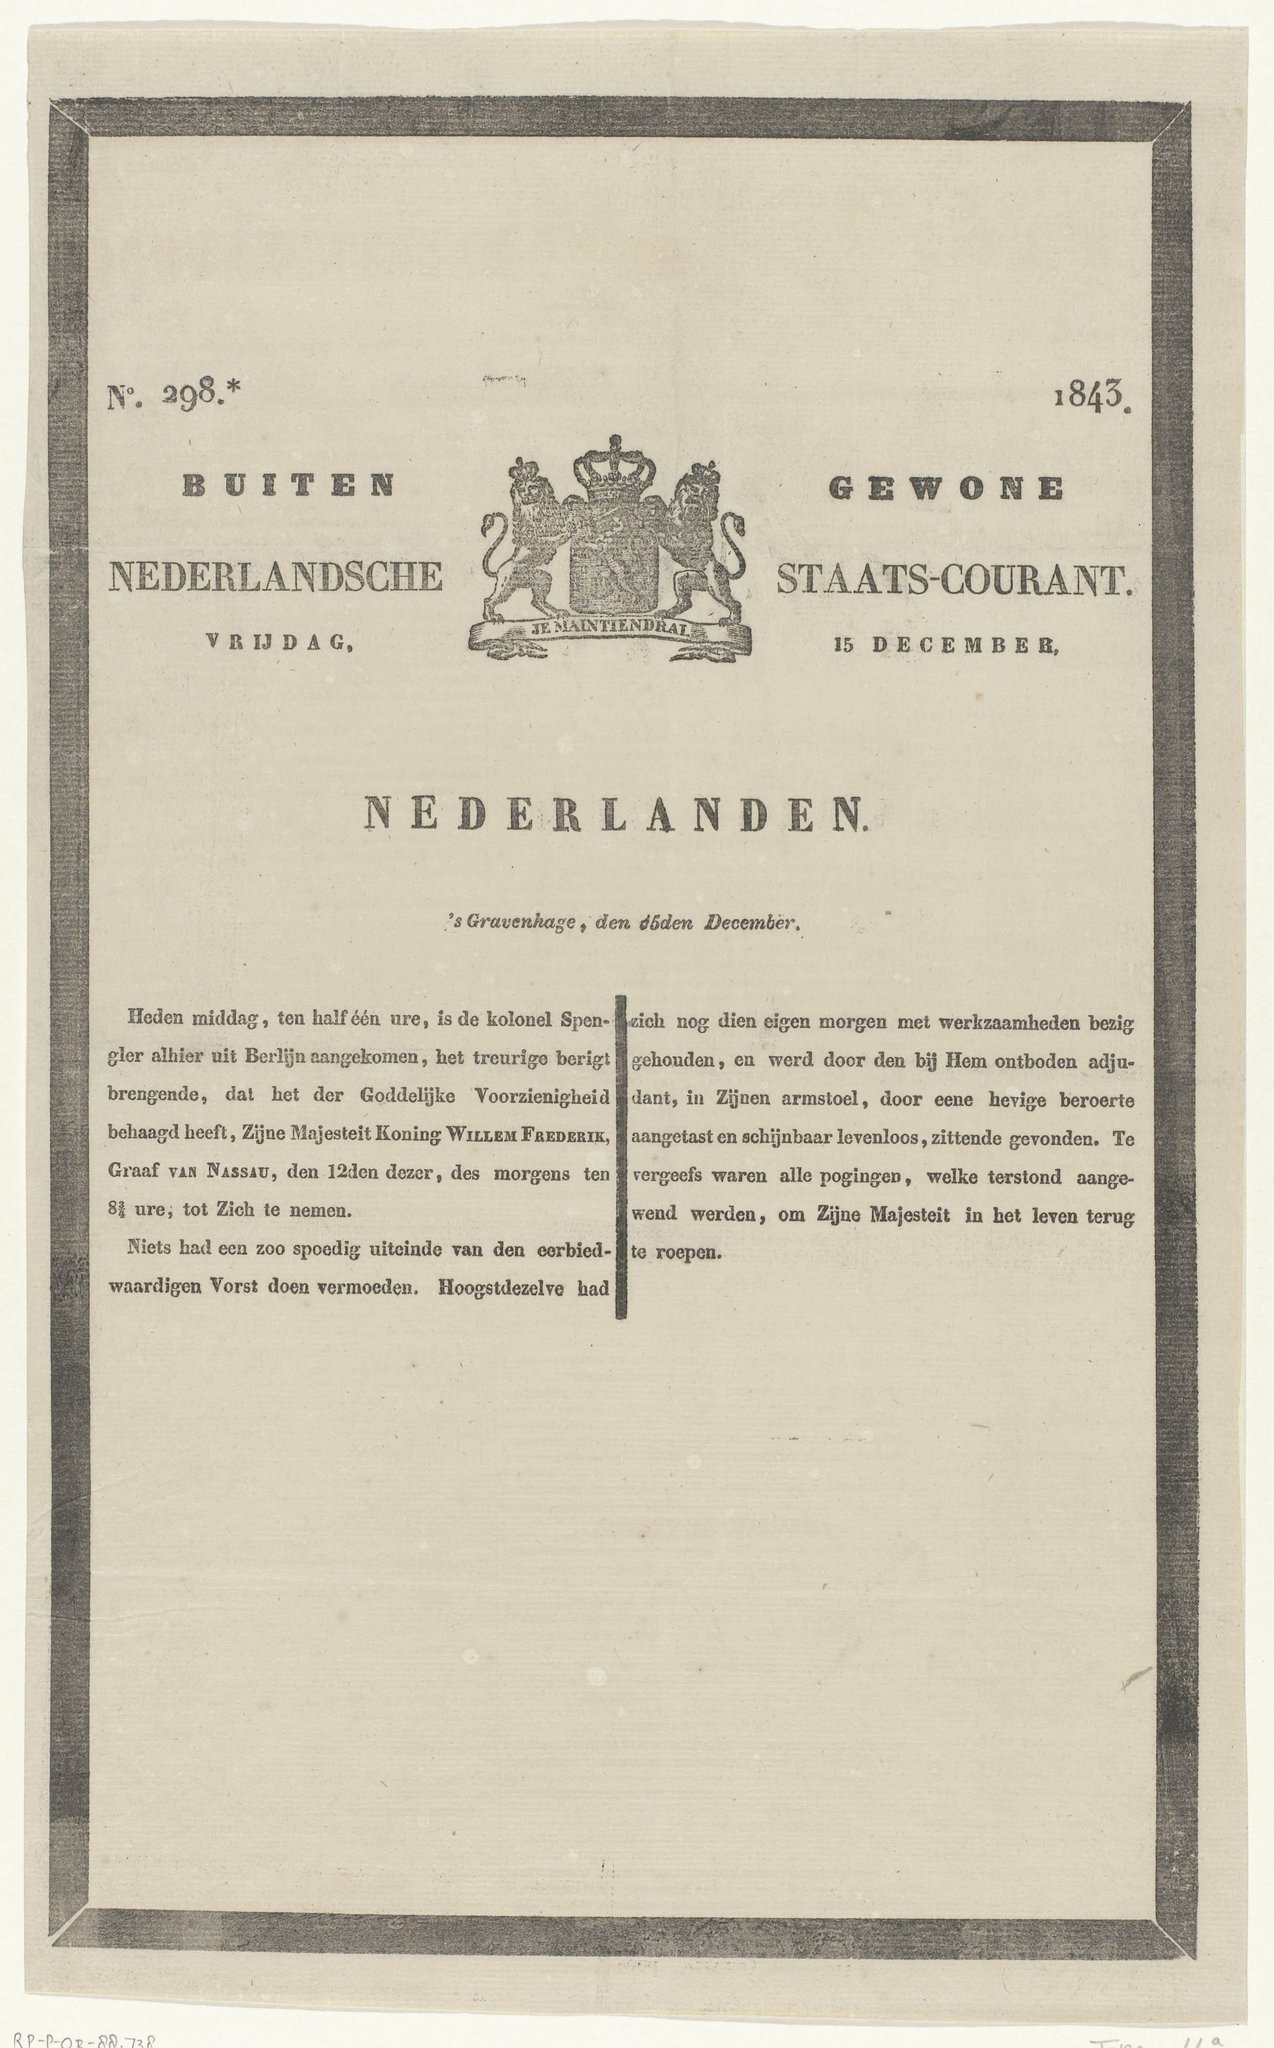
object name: newspaper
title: Buiten Gewone Nederlandsche Staats-Courant. Vrijdag, 15 December. No. 298*. 1843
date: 1843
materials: paper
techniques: letterpress printing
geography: the hague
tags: the hague, berlin, william i of the netherlands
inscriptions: collector's mark: Lugt 2228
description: Extra editie van de Nederlandse Staatscourant van 15 december 1843 met het nieuws van het overlijden van de voormalige koning Willem I te Berlijn op 12 december.